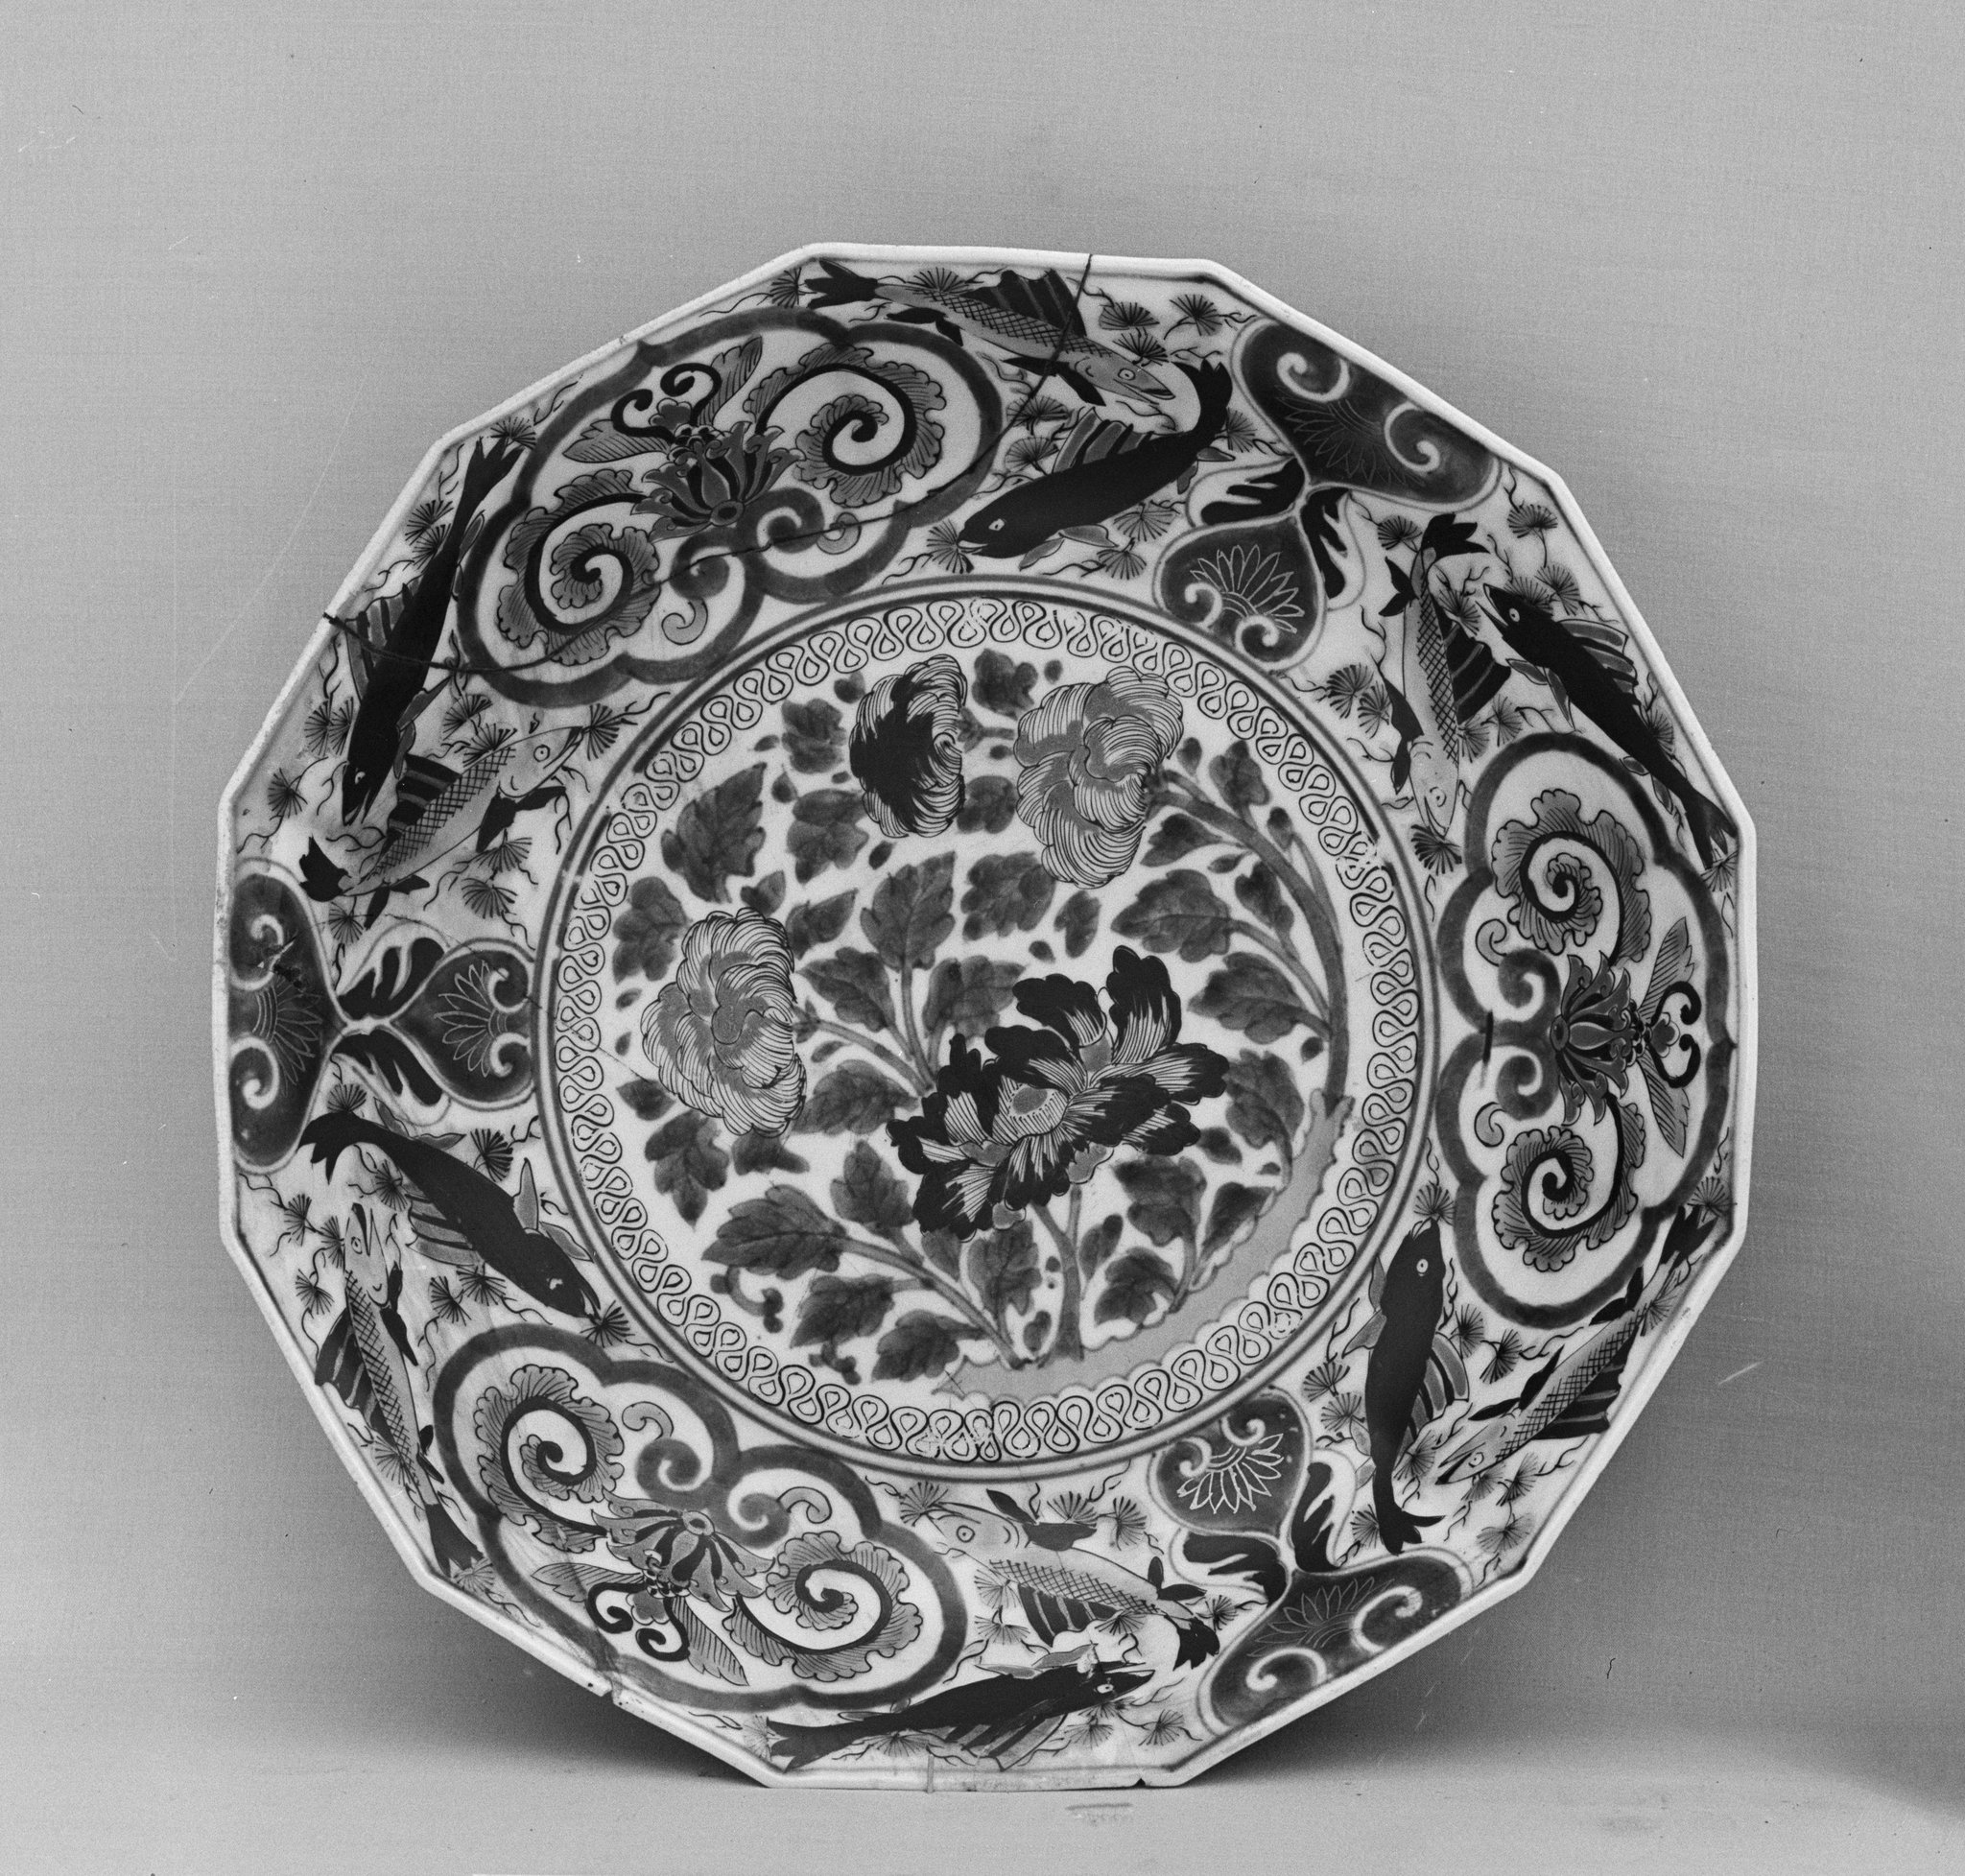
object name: dish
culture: japanese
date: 1720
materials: enamel, glaze, gold, porcelain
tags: fish,flowers,leaves